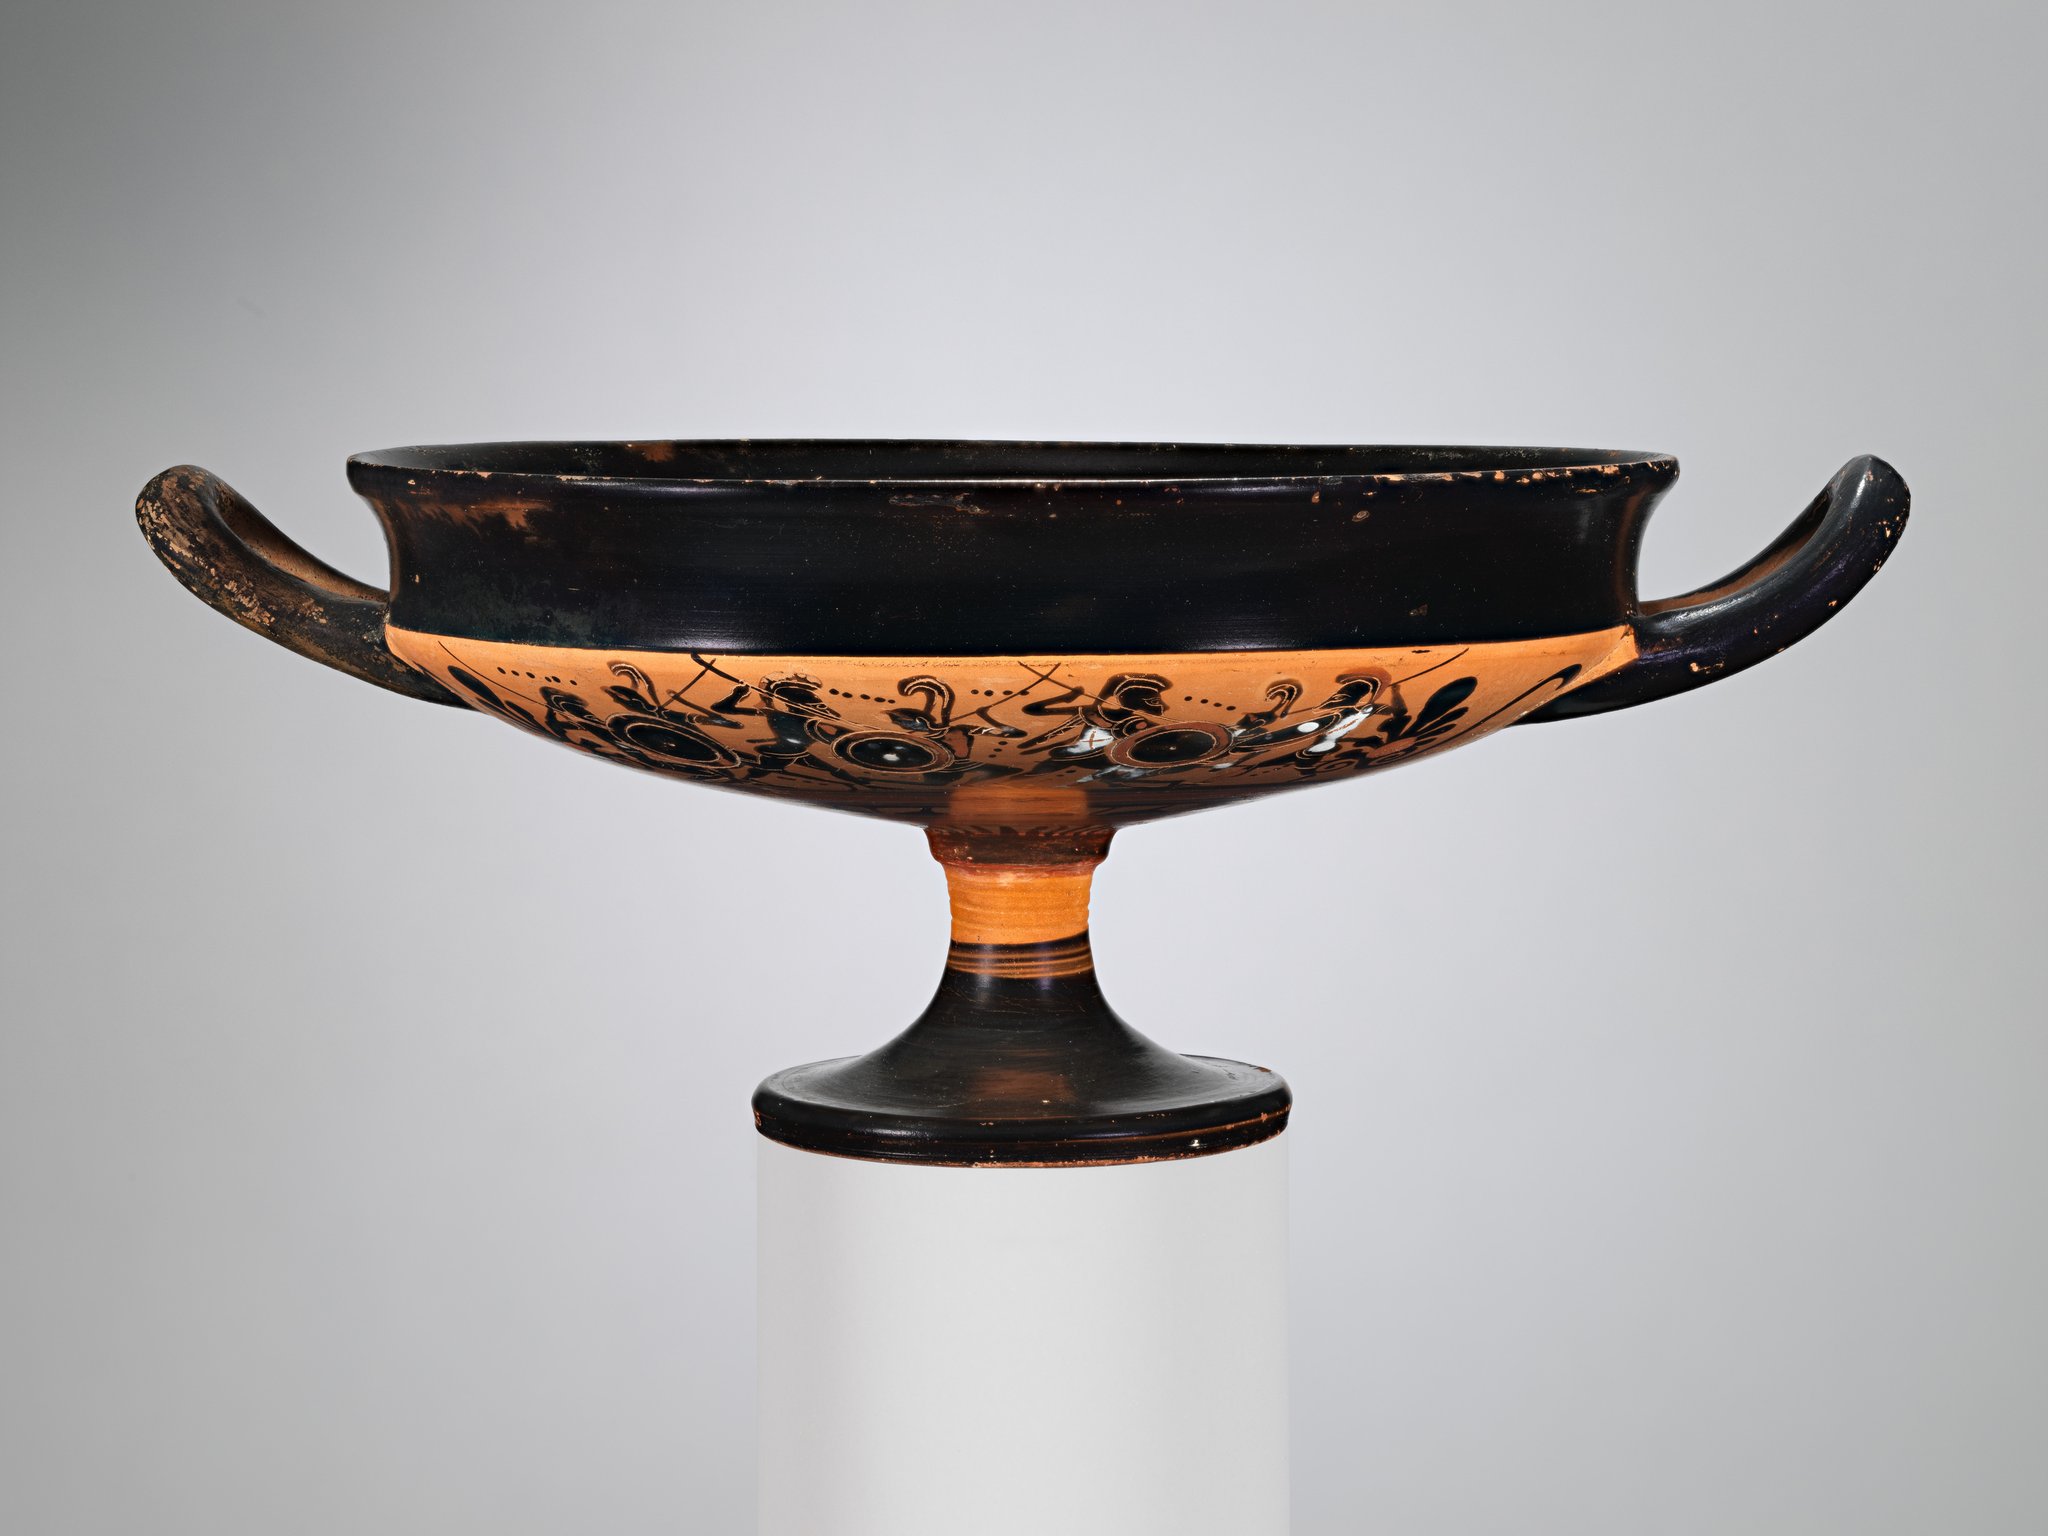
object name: kylix, droop cup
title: Terracotta kylix (drinking cup)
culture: greek, attic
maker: group of rhodes 12264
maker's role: artist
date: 540 BCE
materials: terracotta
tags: battles,amazons